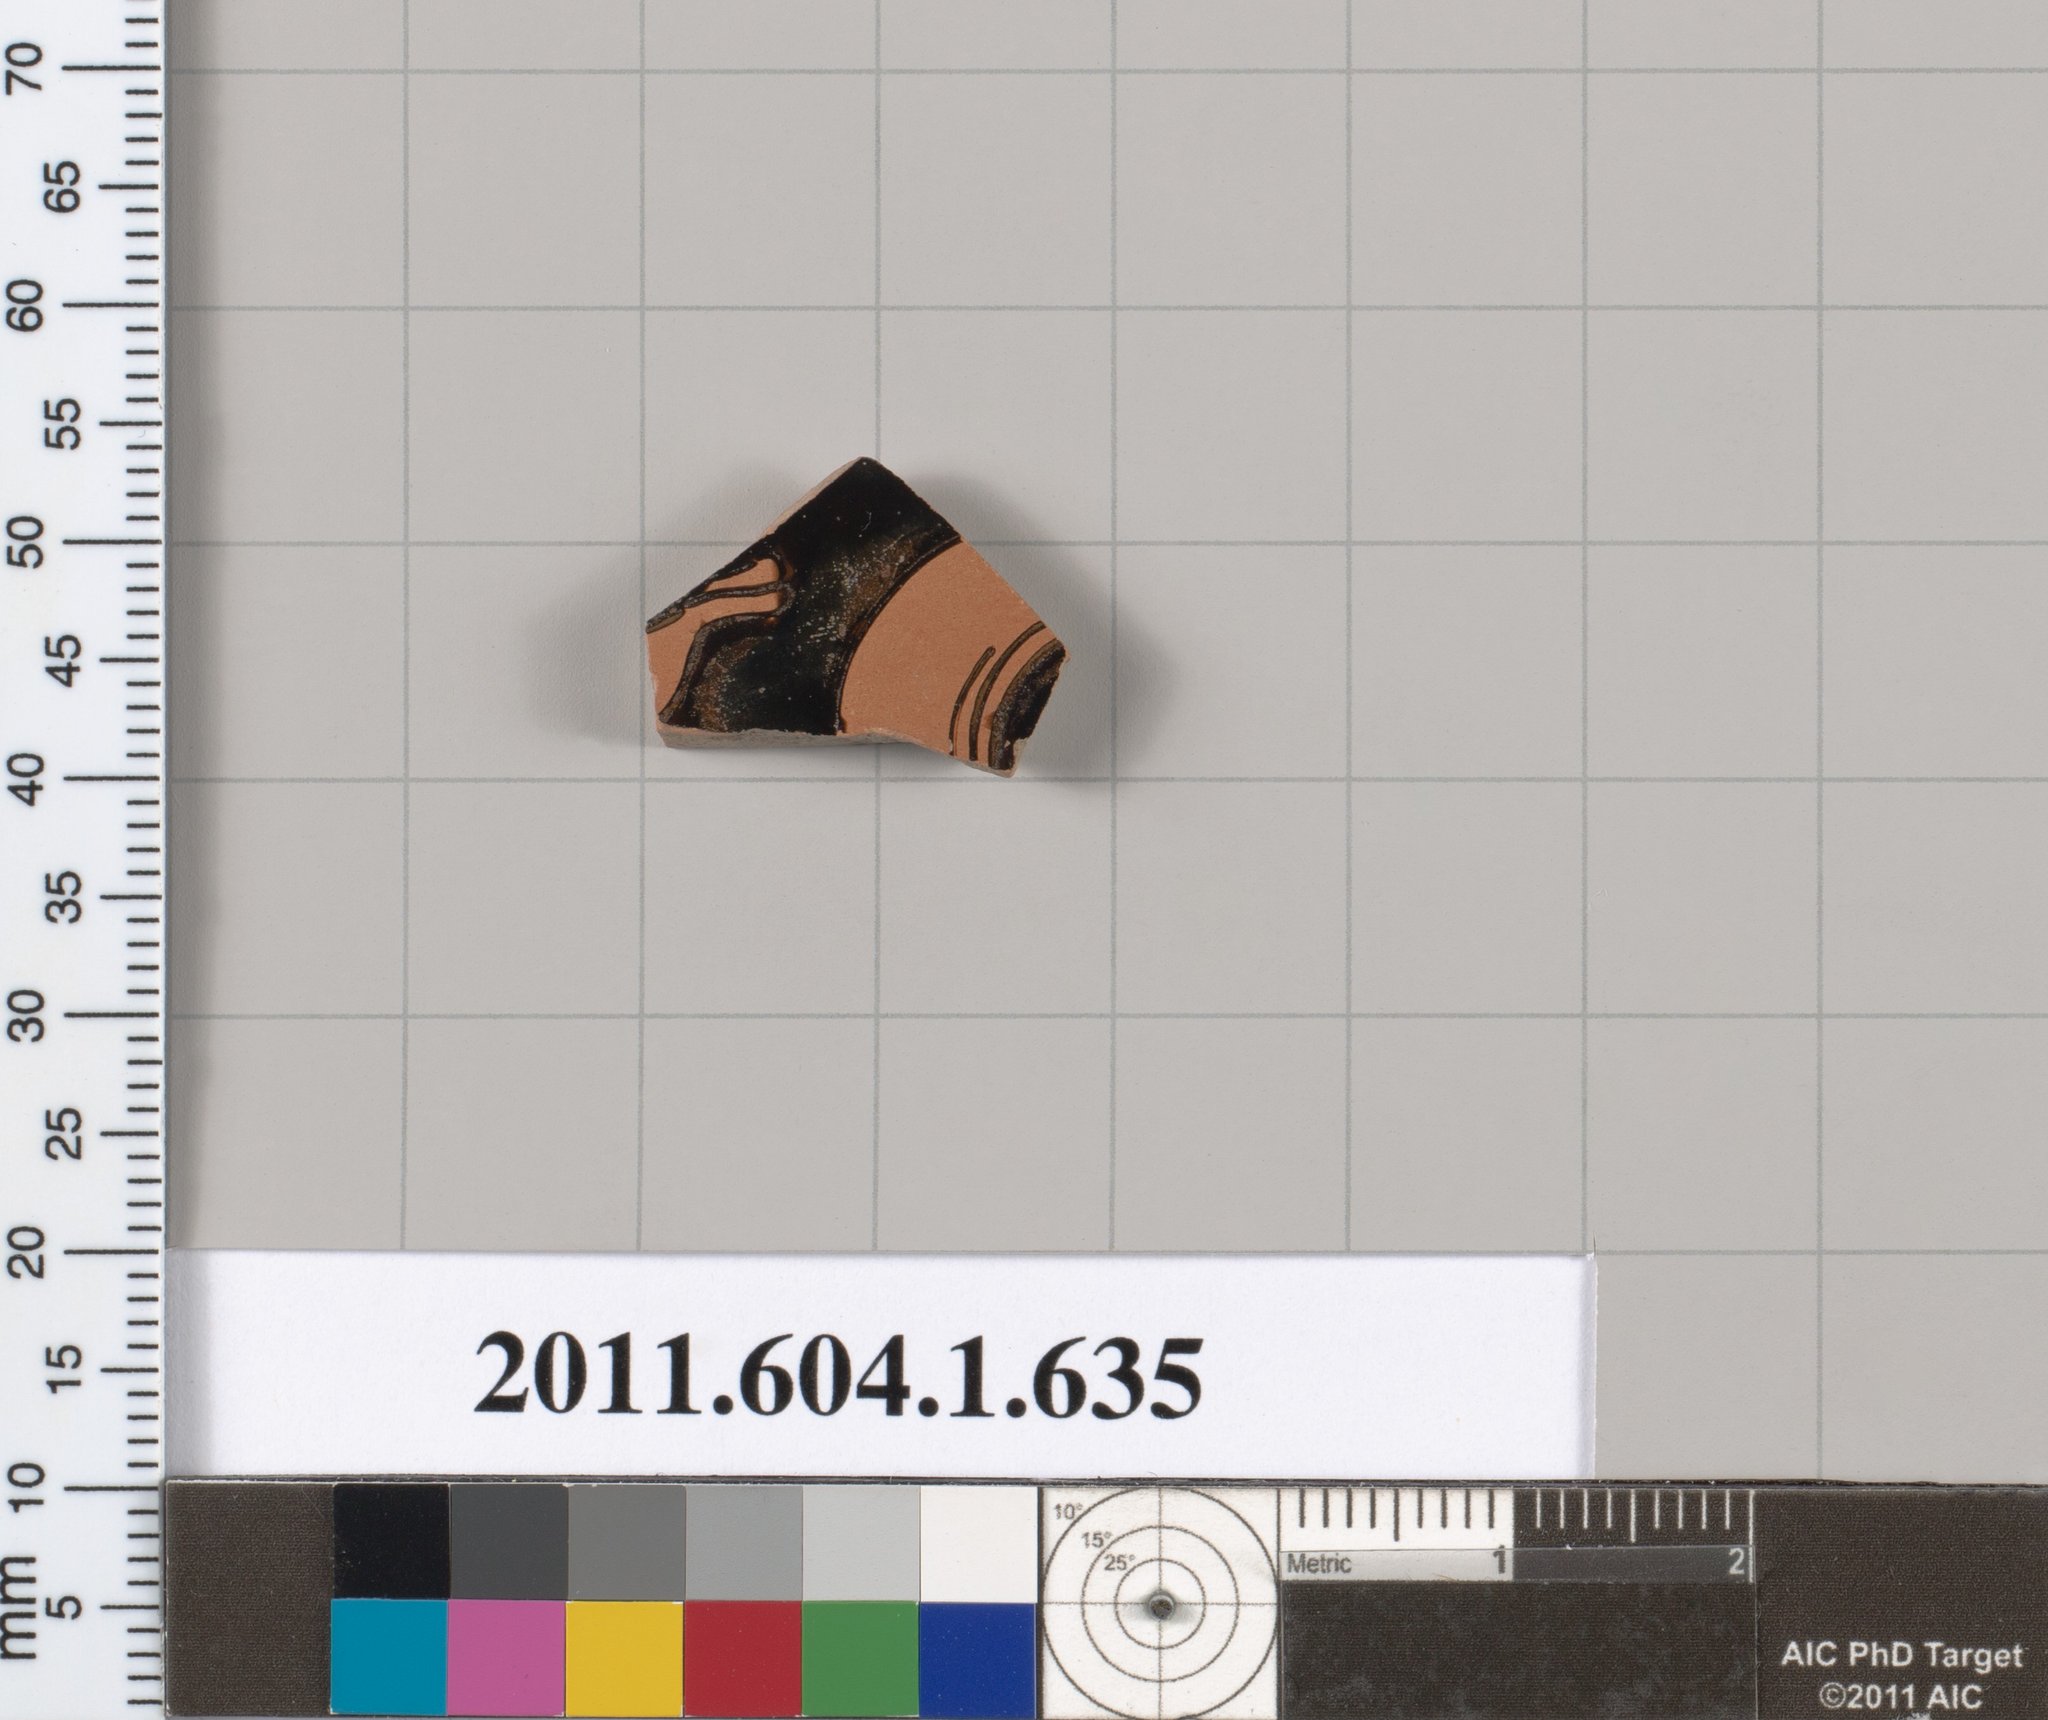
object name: kylix fragment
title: Terracotta fragment of a kylix (drinking cup)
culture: greek, attic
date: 475-451 BCE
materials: terracotta